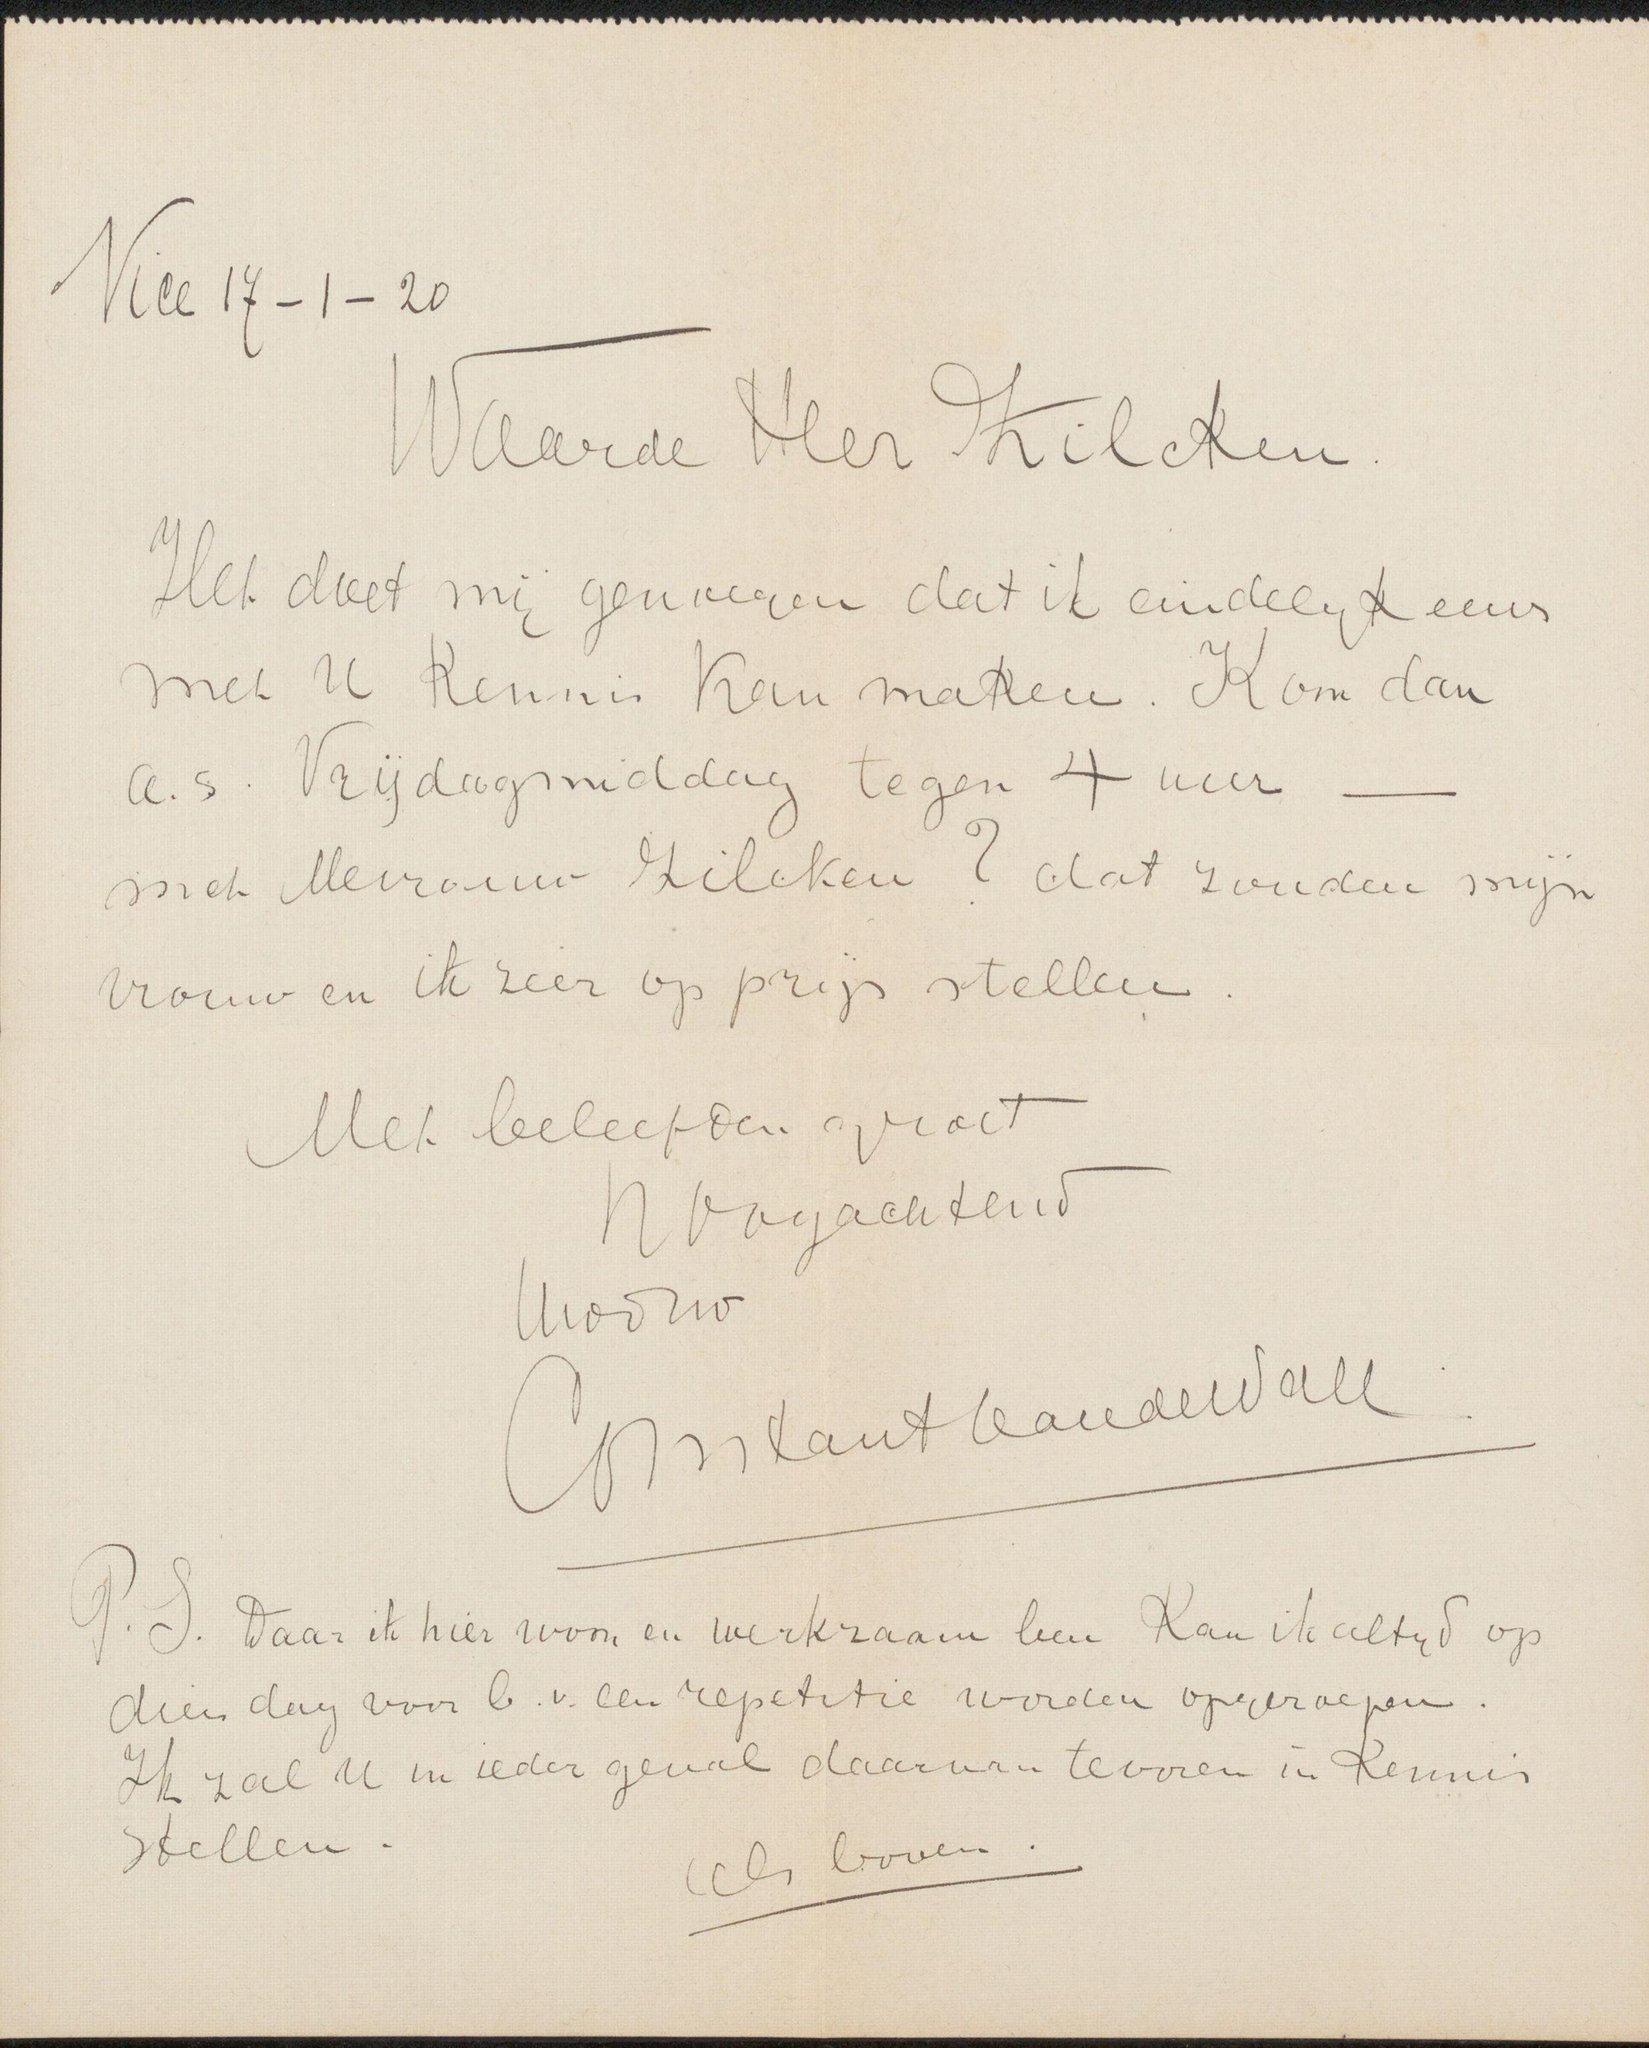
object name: letter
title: Brief aan Philip Zilcken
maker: johan constant arnold van de wall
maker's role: componist, dirigent, docent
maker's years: 1871-1945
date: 1920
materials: ink, paper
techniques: pen, writing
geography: nice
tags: the hague, painter, draughtsman, philip zilcken, music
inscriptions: address: ‘CONSTANT VAN DE WALL/ PALAIS TONY PIN/ Boulevard de Cimiez/ NICE’, collector's mark: ‘RPK’